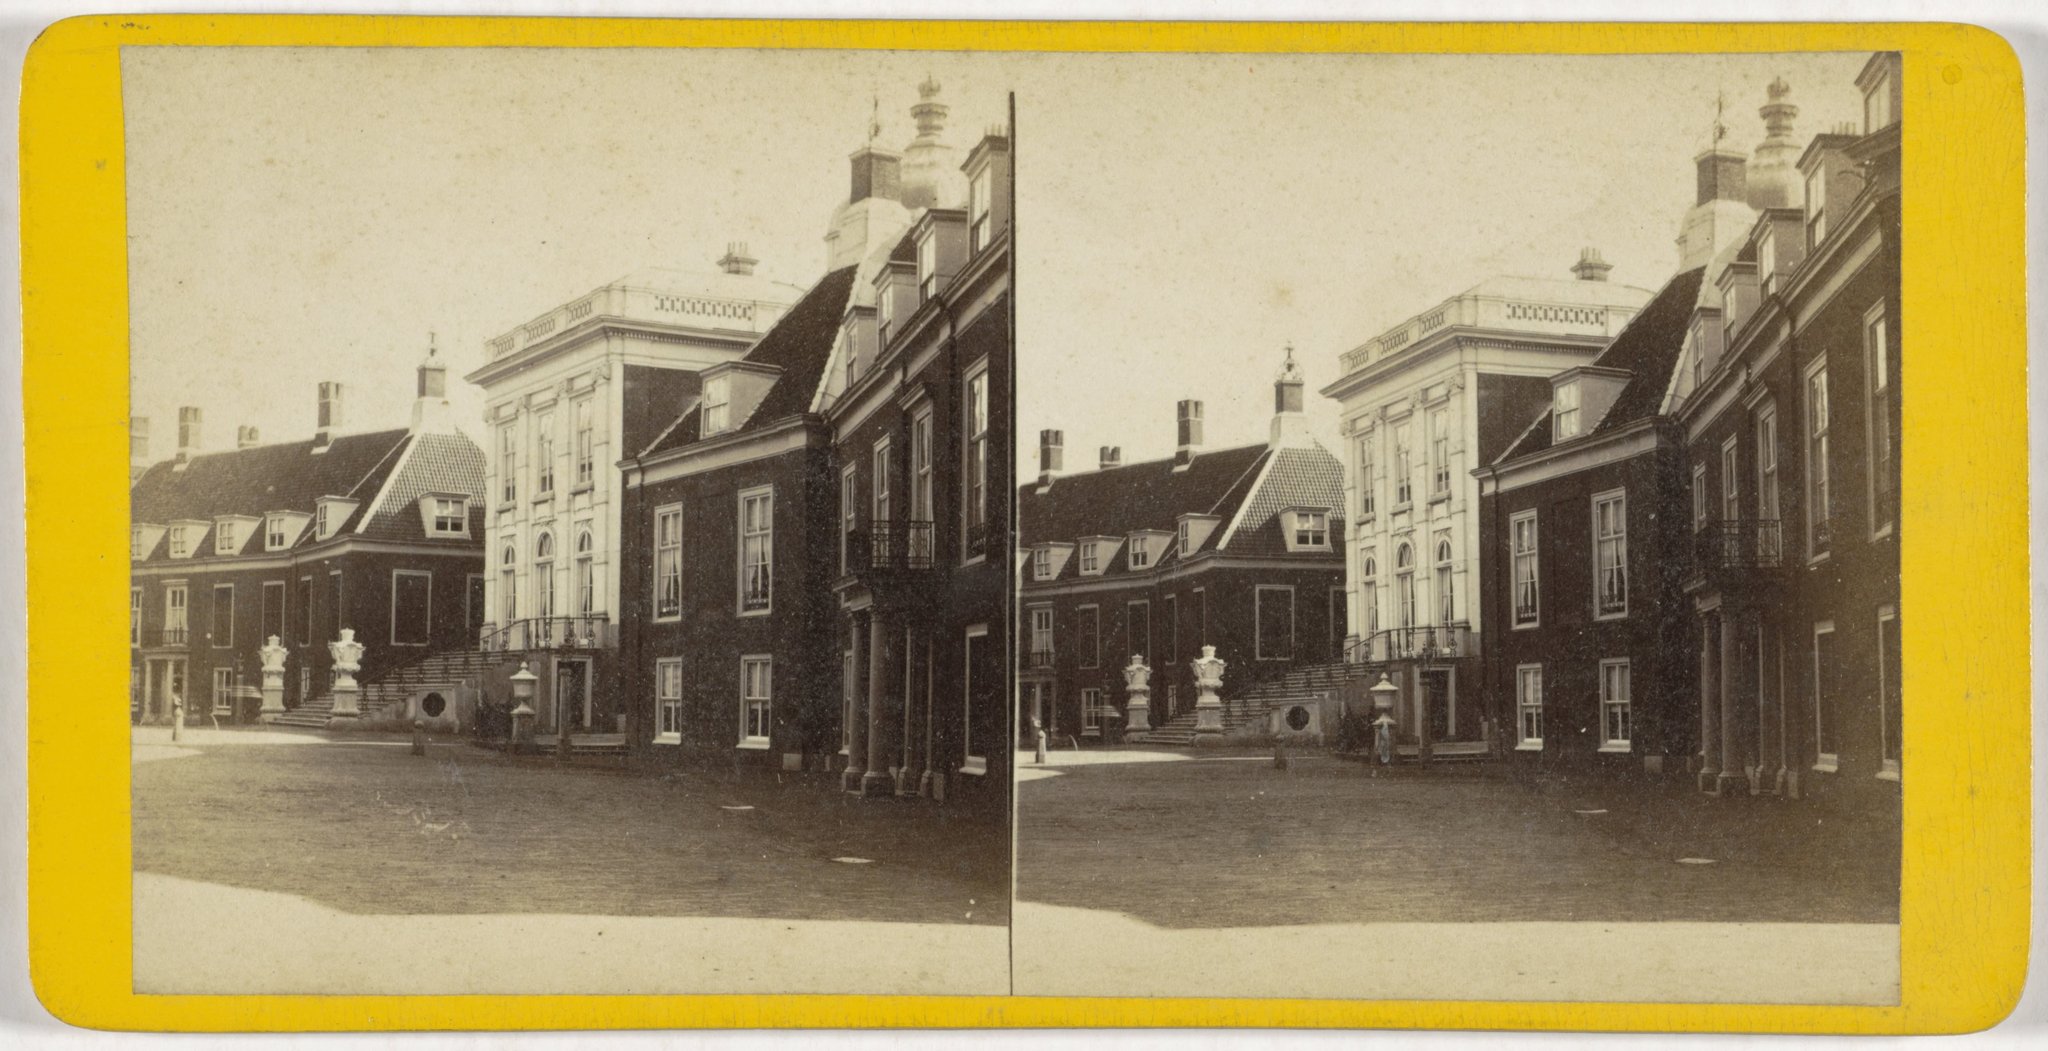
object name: stereograph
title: Gezicht op Paleis Huis ten Bosch in Den Haag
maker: Anonymous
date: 1868-1890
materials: cardboard, paper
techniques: albumen print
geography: the hague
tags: palace, the hague